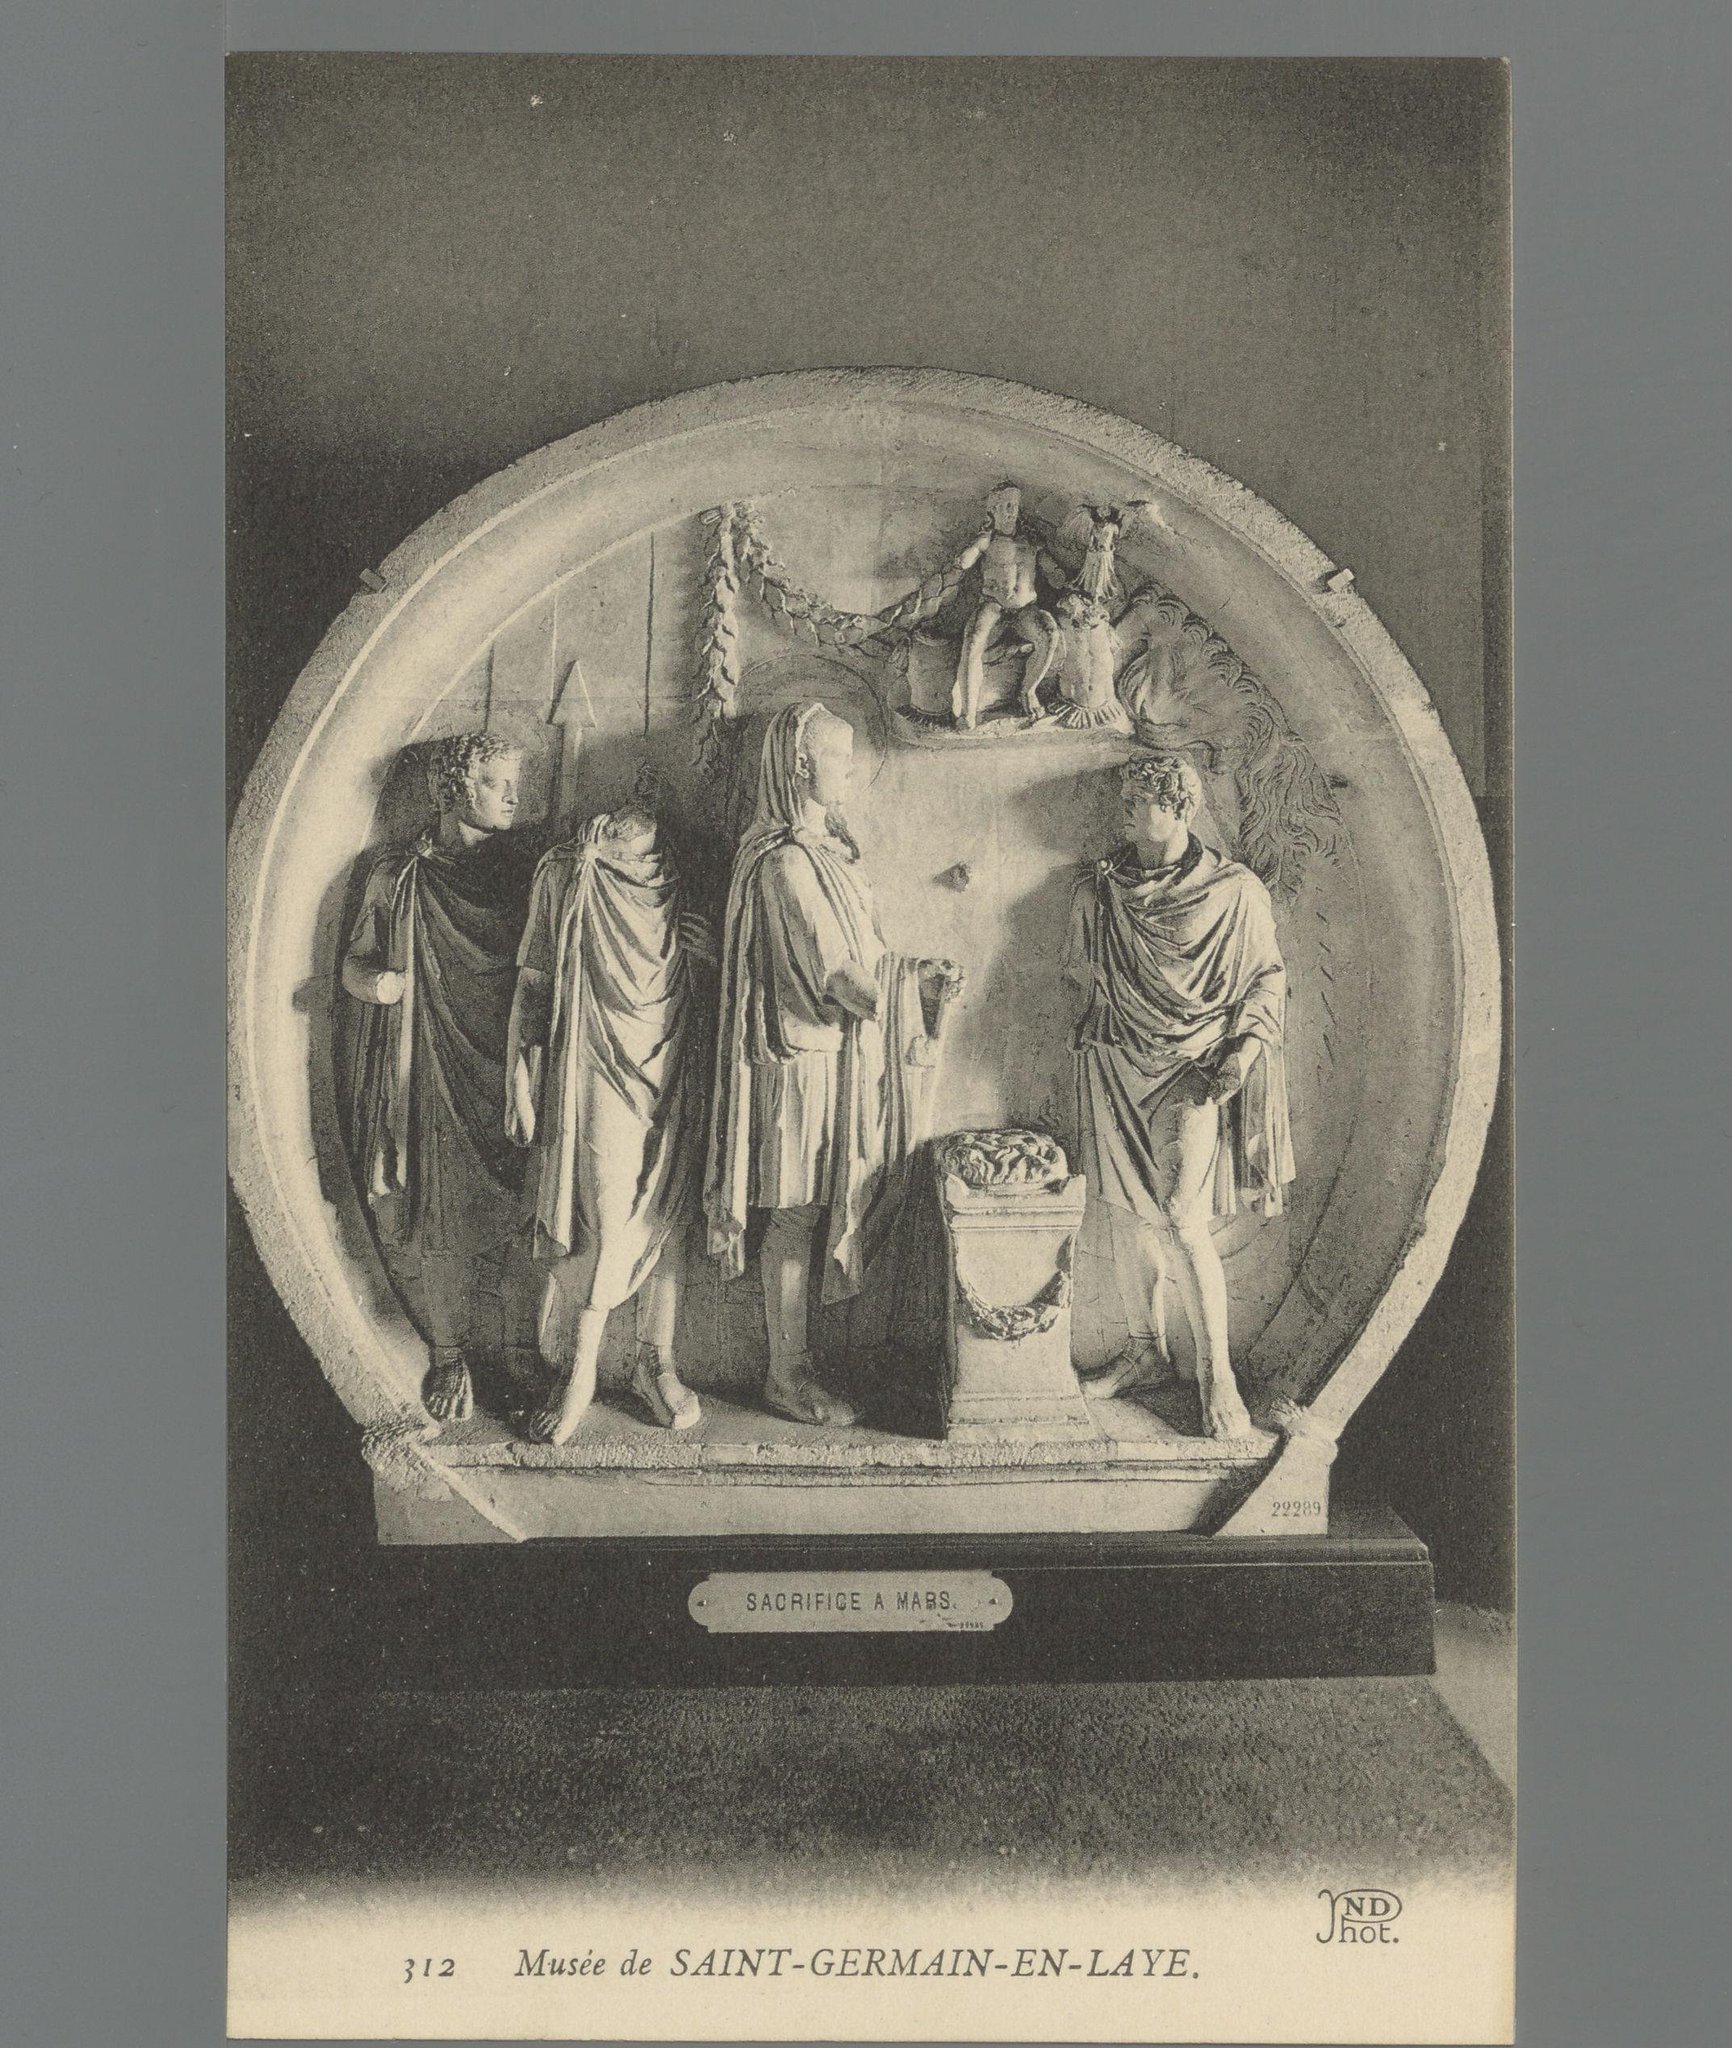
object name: photomechanical print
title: Musée de Saint-Germain-en-Laye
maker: Anonymous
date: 1903-1918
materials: cardboard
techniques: photograph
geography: saint-germain-en-laye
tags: permanent exhibition, museum, sculpture